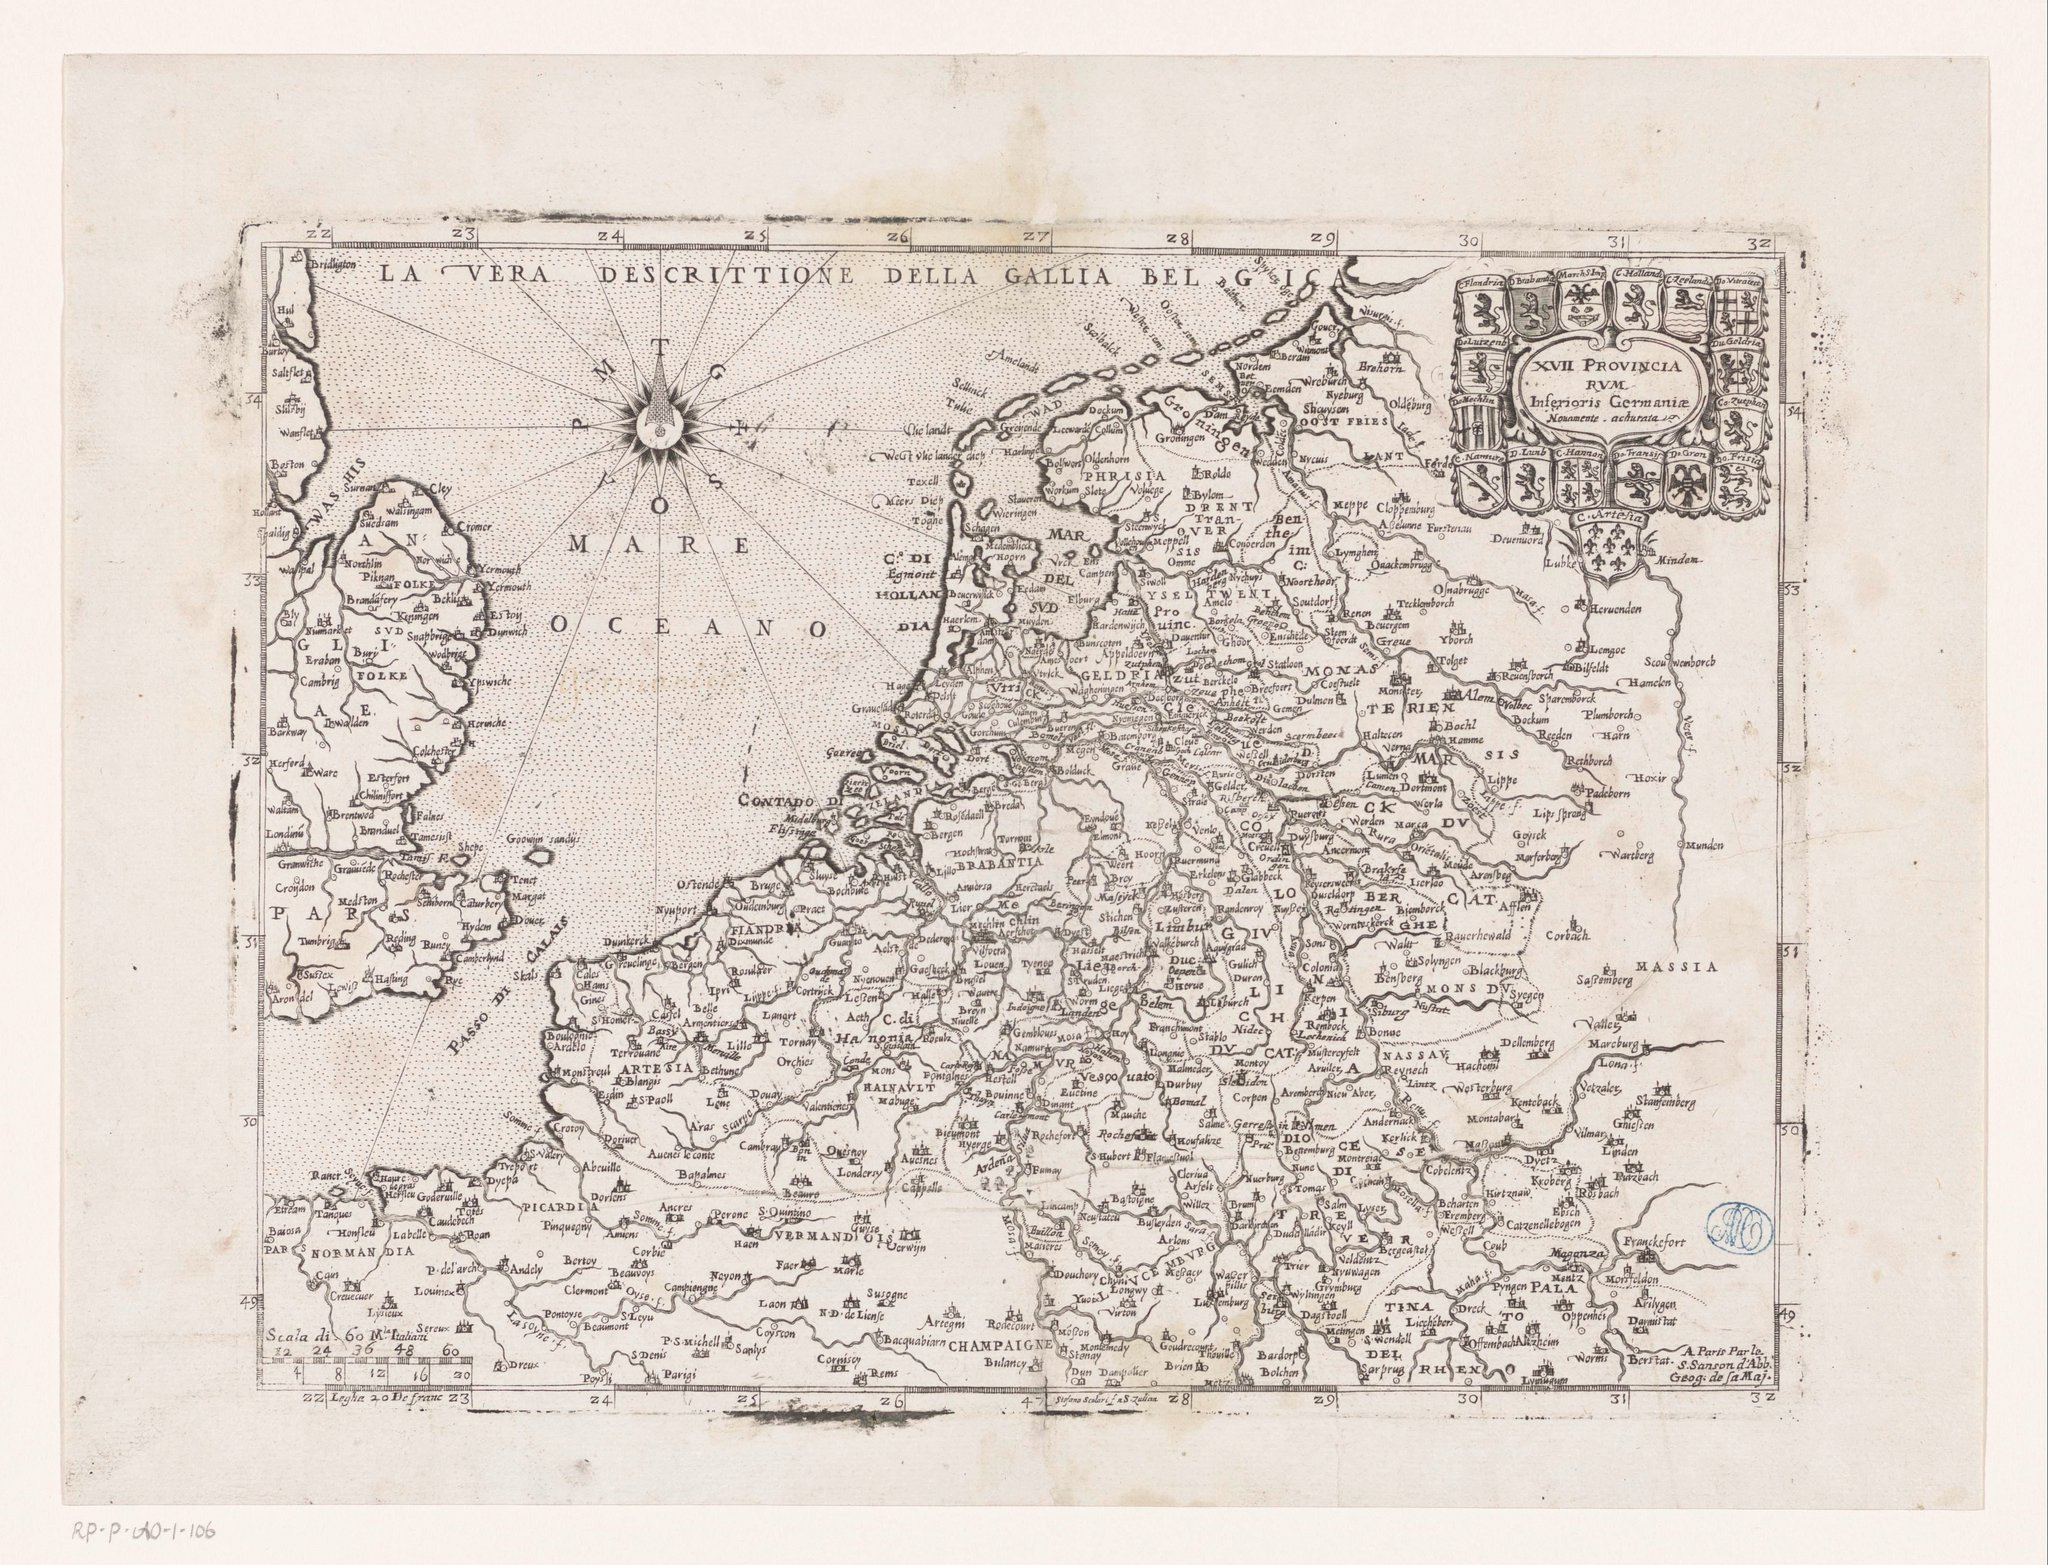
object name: print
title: Kaart van de Zeventien Provinciën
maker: stefano scolari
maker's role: print maker, printer, publisher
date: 1560-1565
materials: paper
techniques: engraving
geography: venice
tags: coat of arms (as symbol of the state, etc.), maps of separate countries or regions, low countries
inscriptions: collector's mark: Lugt 195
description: Rechtsboven titelcartouche met daaromheen de wapens van de Zeventien Provinciën. Linksonder twee schaalstokken: Scala di 60 Mla Italiatti, Leghe 20 de Franc. Gradenverdeling langs de randen.